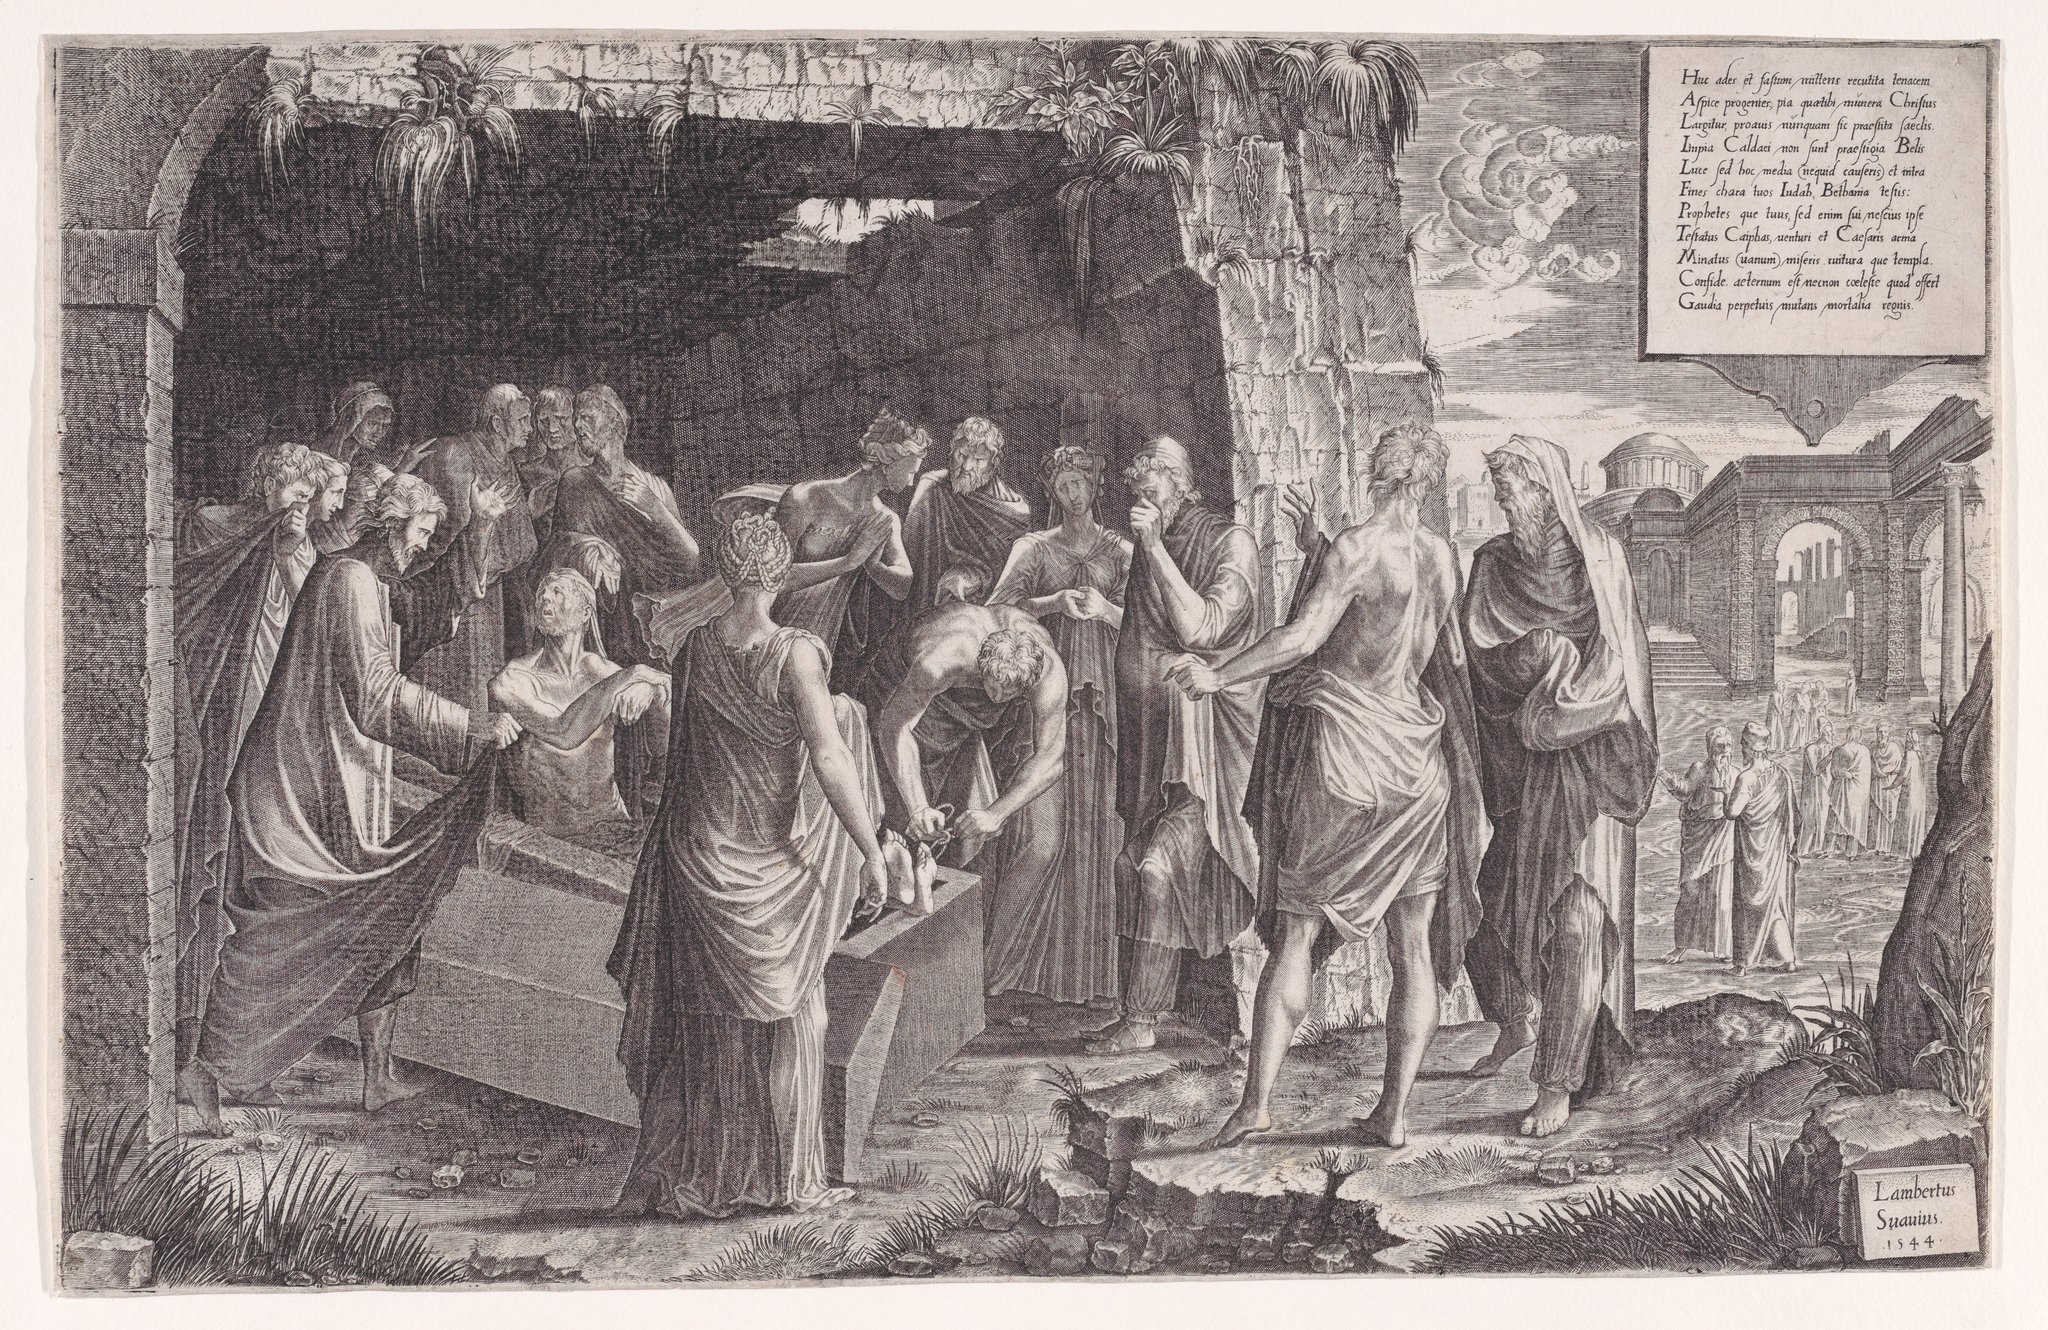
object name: print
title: The Raising of Lazarus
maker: lambert suavius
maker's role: artist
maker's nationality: netherlandish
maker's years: 1510-1576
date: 1544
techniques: engraving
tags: men,women,saints